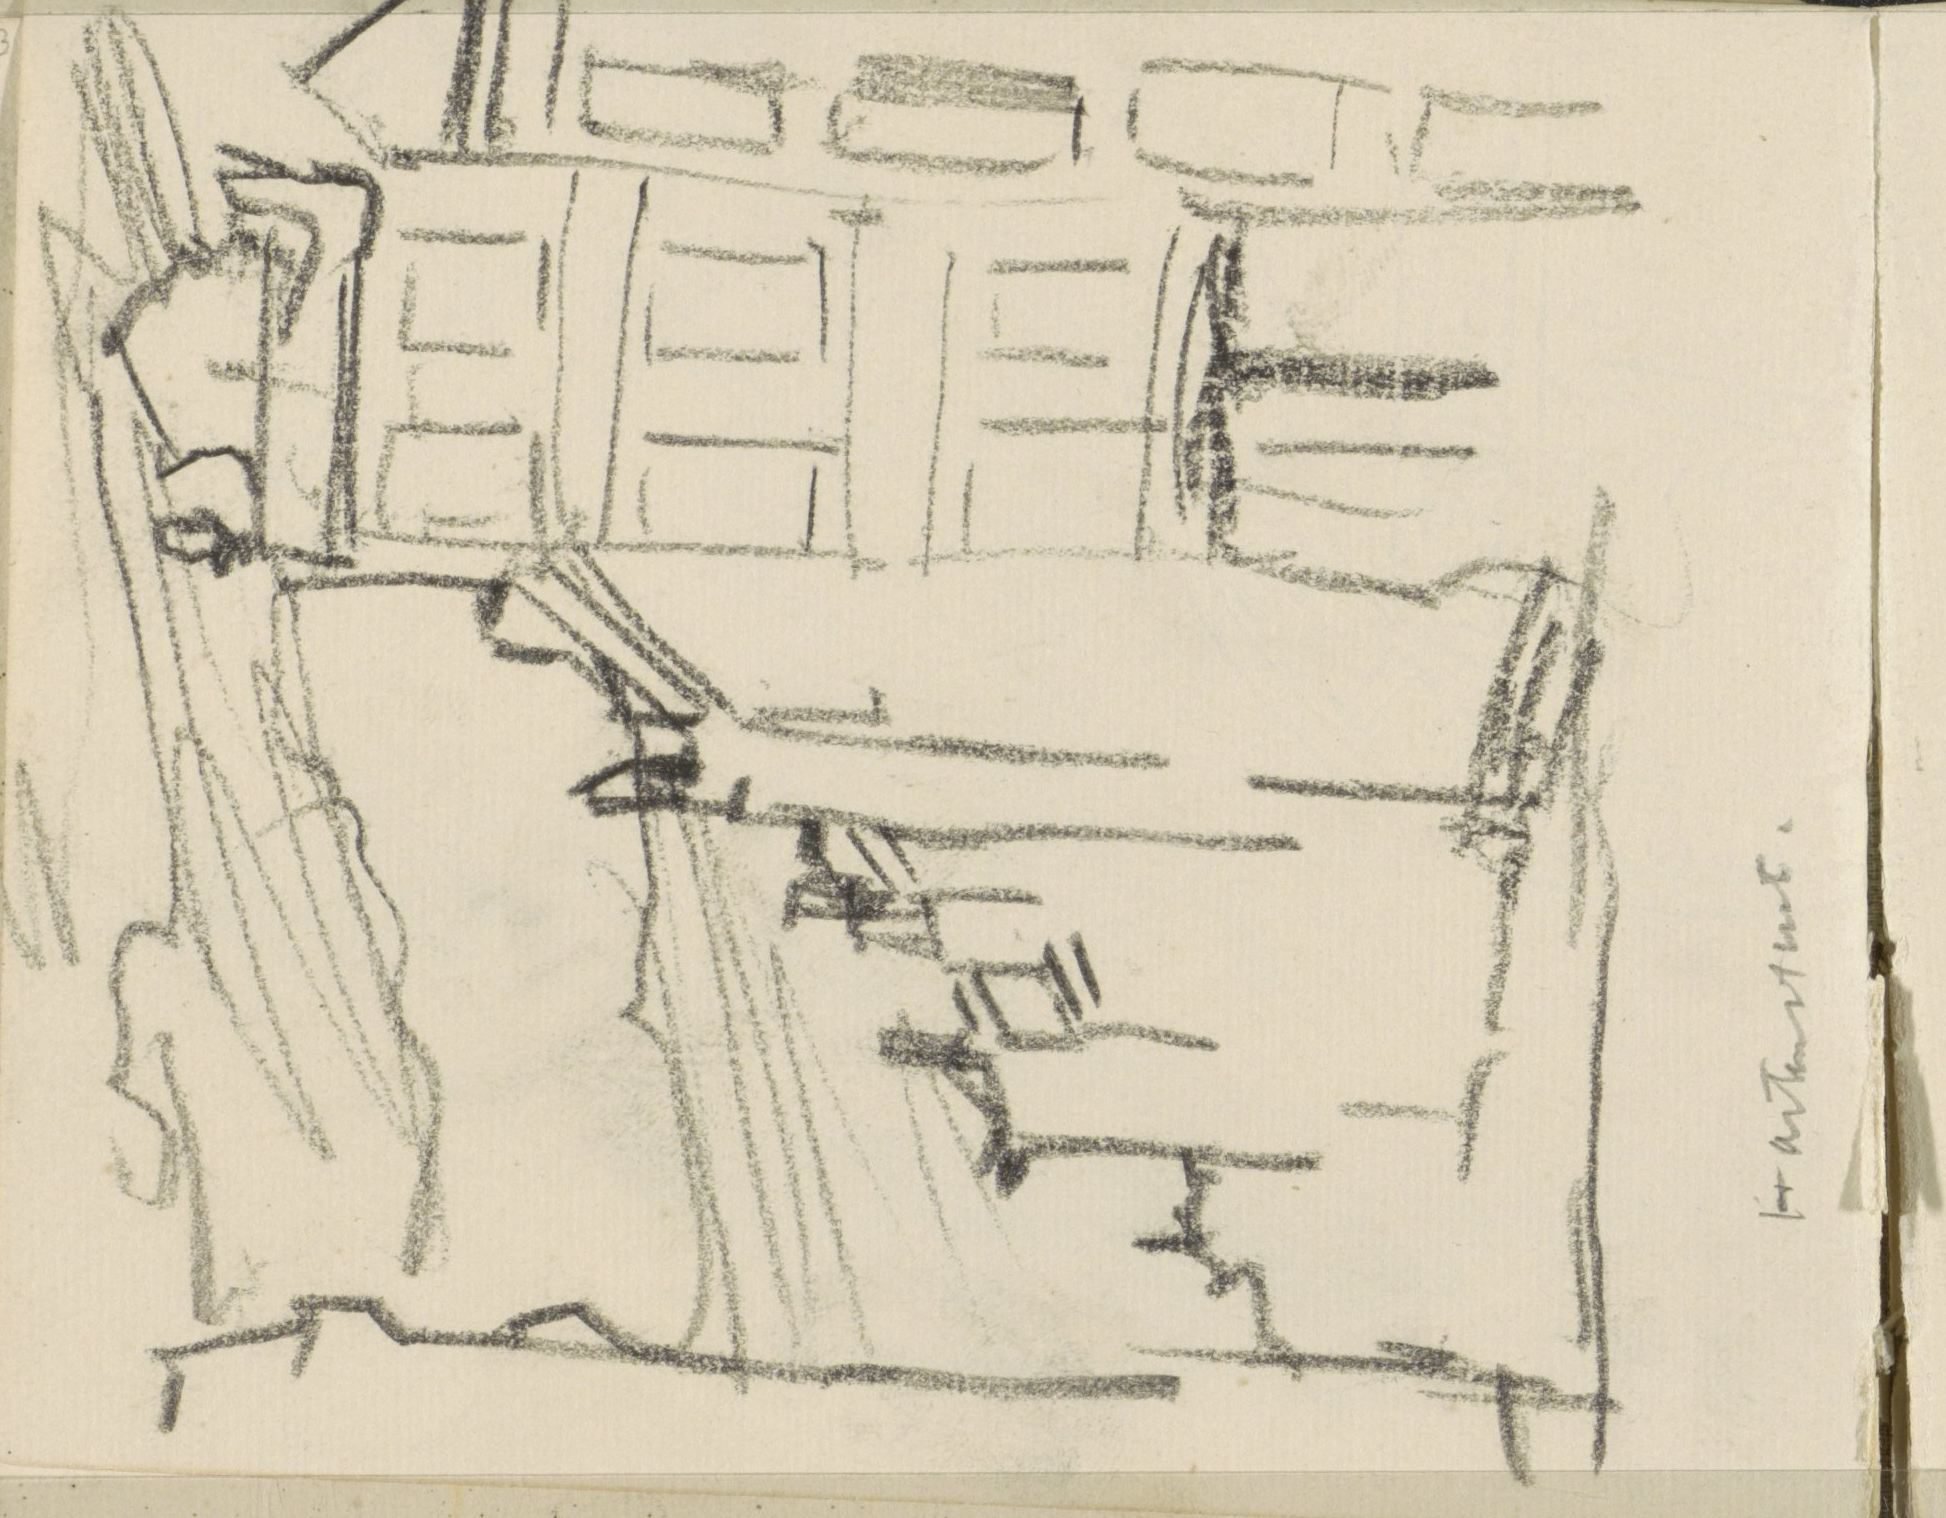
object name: sketchbook leaf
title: Gezicht op de Hartenstraat te Amsterdam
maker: george hendrik breitner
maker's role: draughtsman, painter, print maker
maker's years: 1857-1923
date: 1885-1898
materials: chalk, paper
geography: amsterdam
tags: civic architecture; edifices; dwellings, street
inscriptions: annotation: ‘Hartenstraat.’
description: Gezien vanaf de brug over de Herengracht. Pagina 55 uit een schetsboek met 32 bladen.